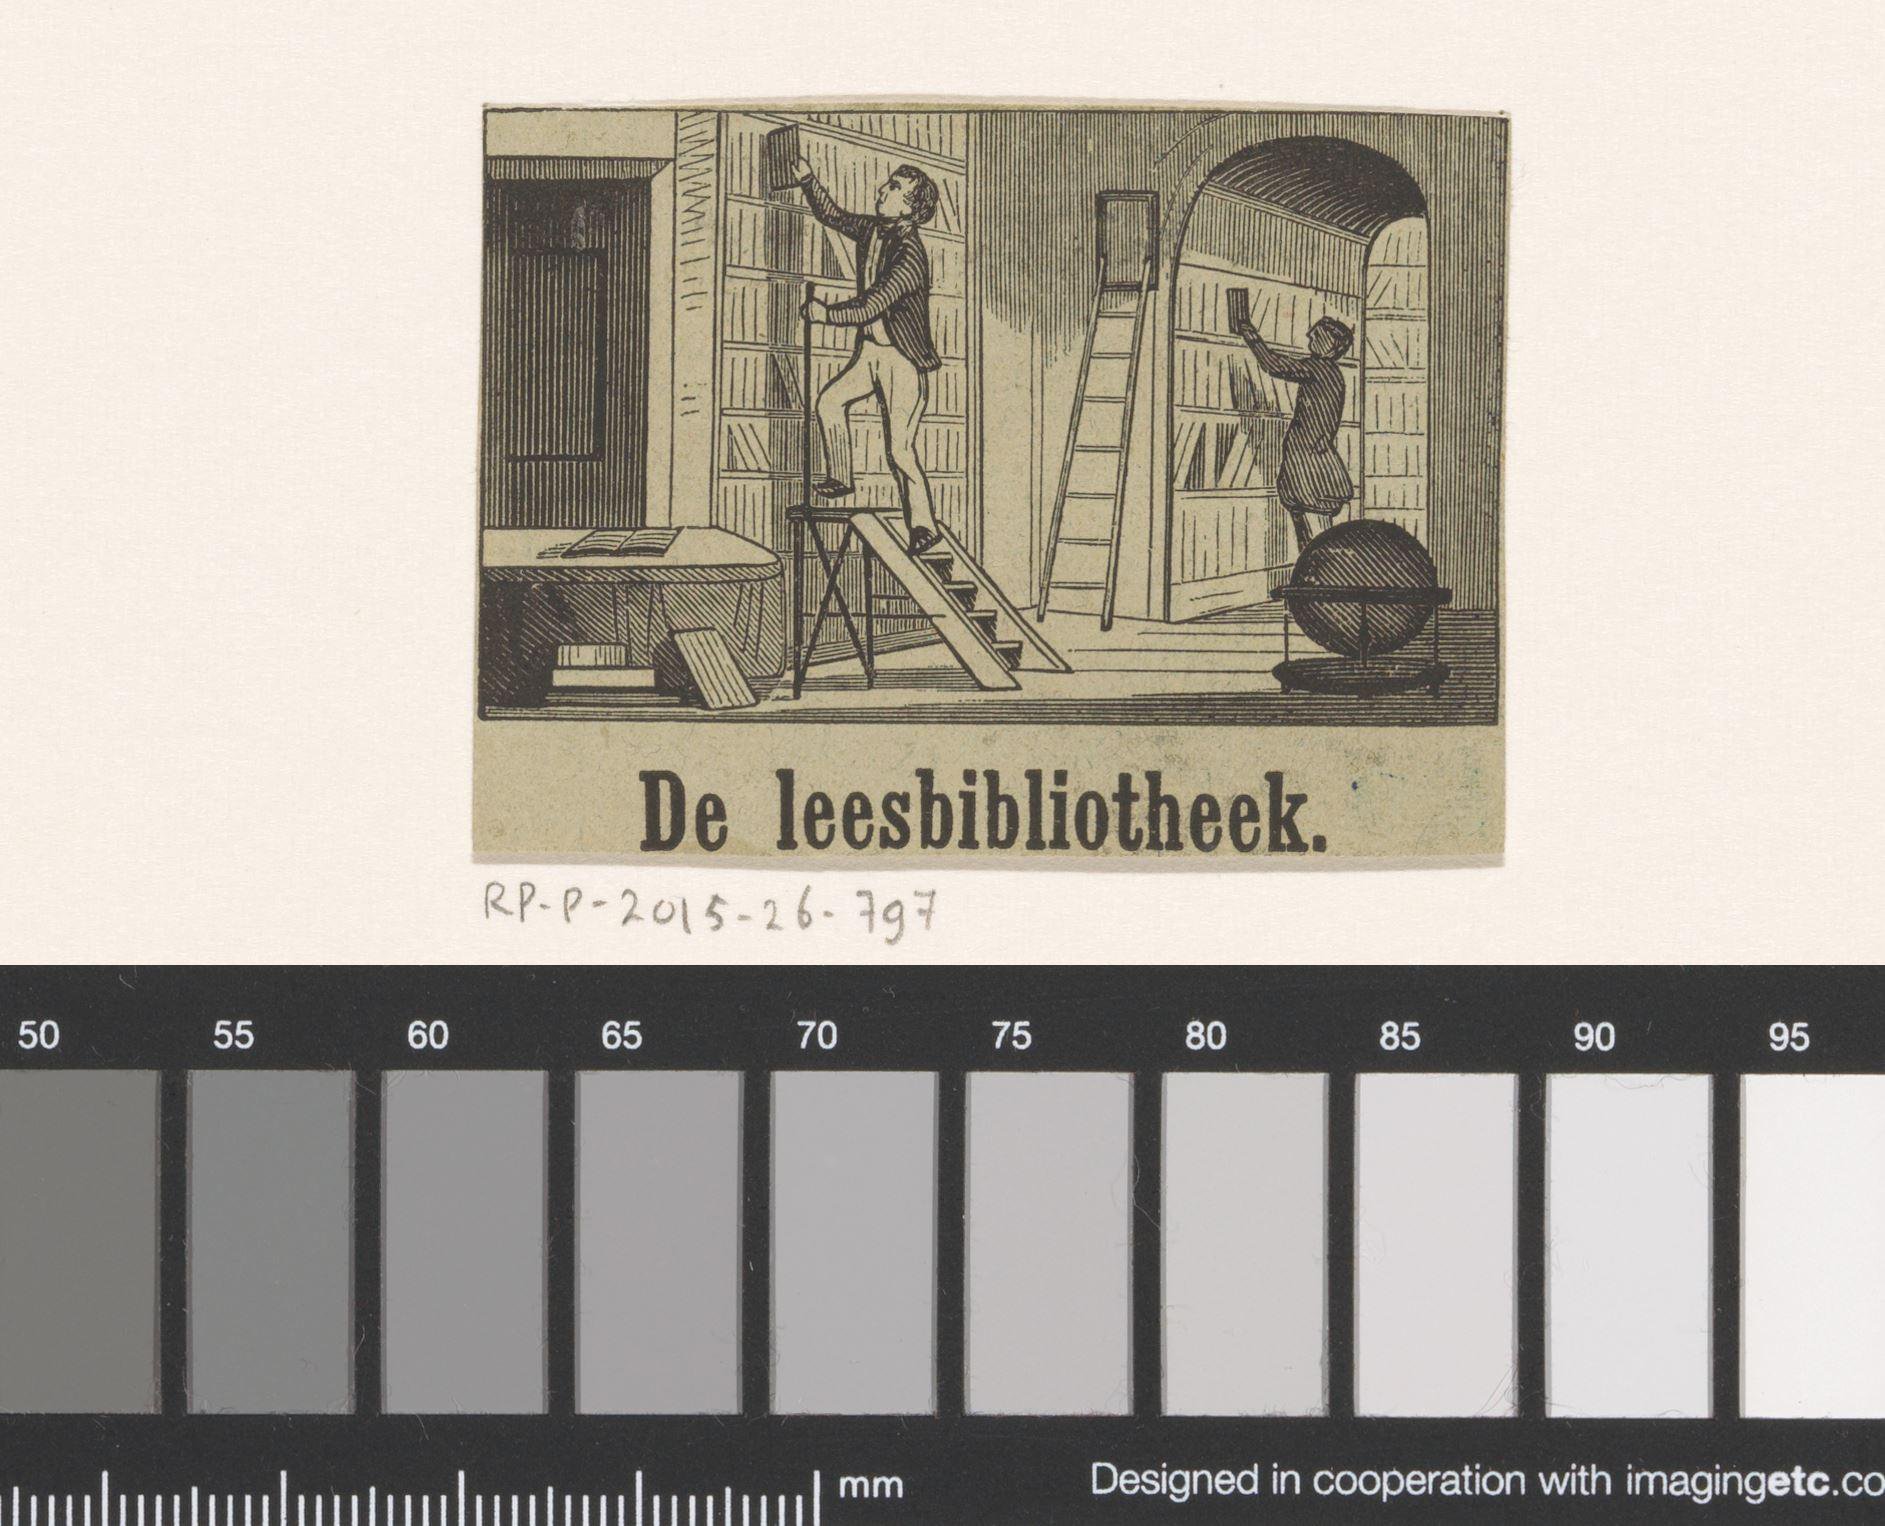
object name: print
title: De leesbibliotheek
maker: Anonymous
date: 1800-1899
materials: paper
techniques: engraving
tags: bookshelves, public library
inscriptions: collector's mark: Lugt 2228, collector's mark: Lugt 4780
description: Een man op een bibliotheektrapje pakt een boek uit de kast, op de voorgrond een globe.